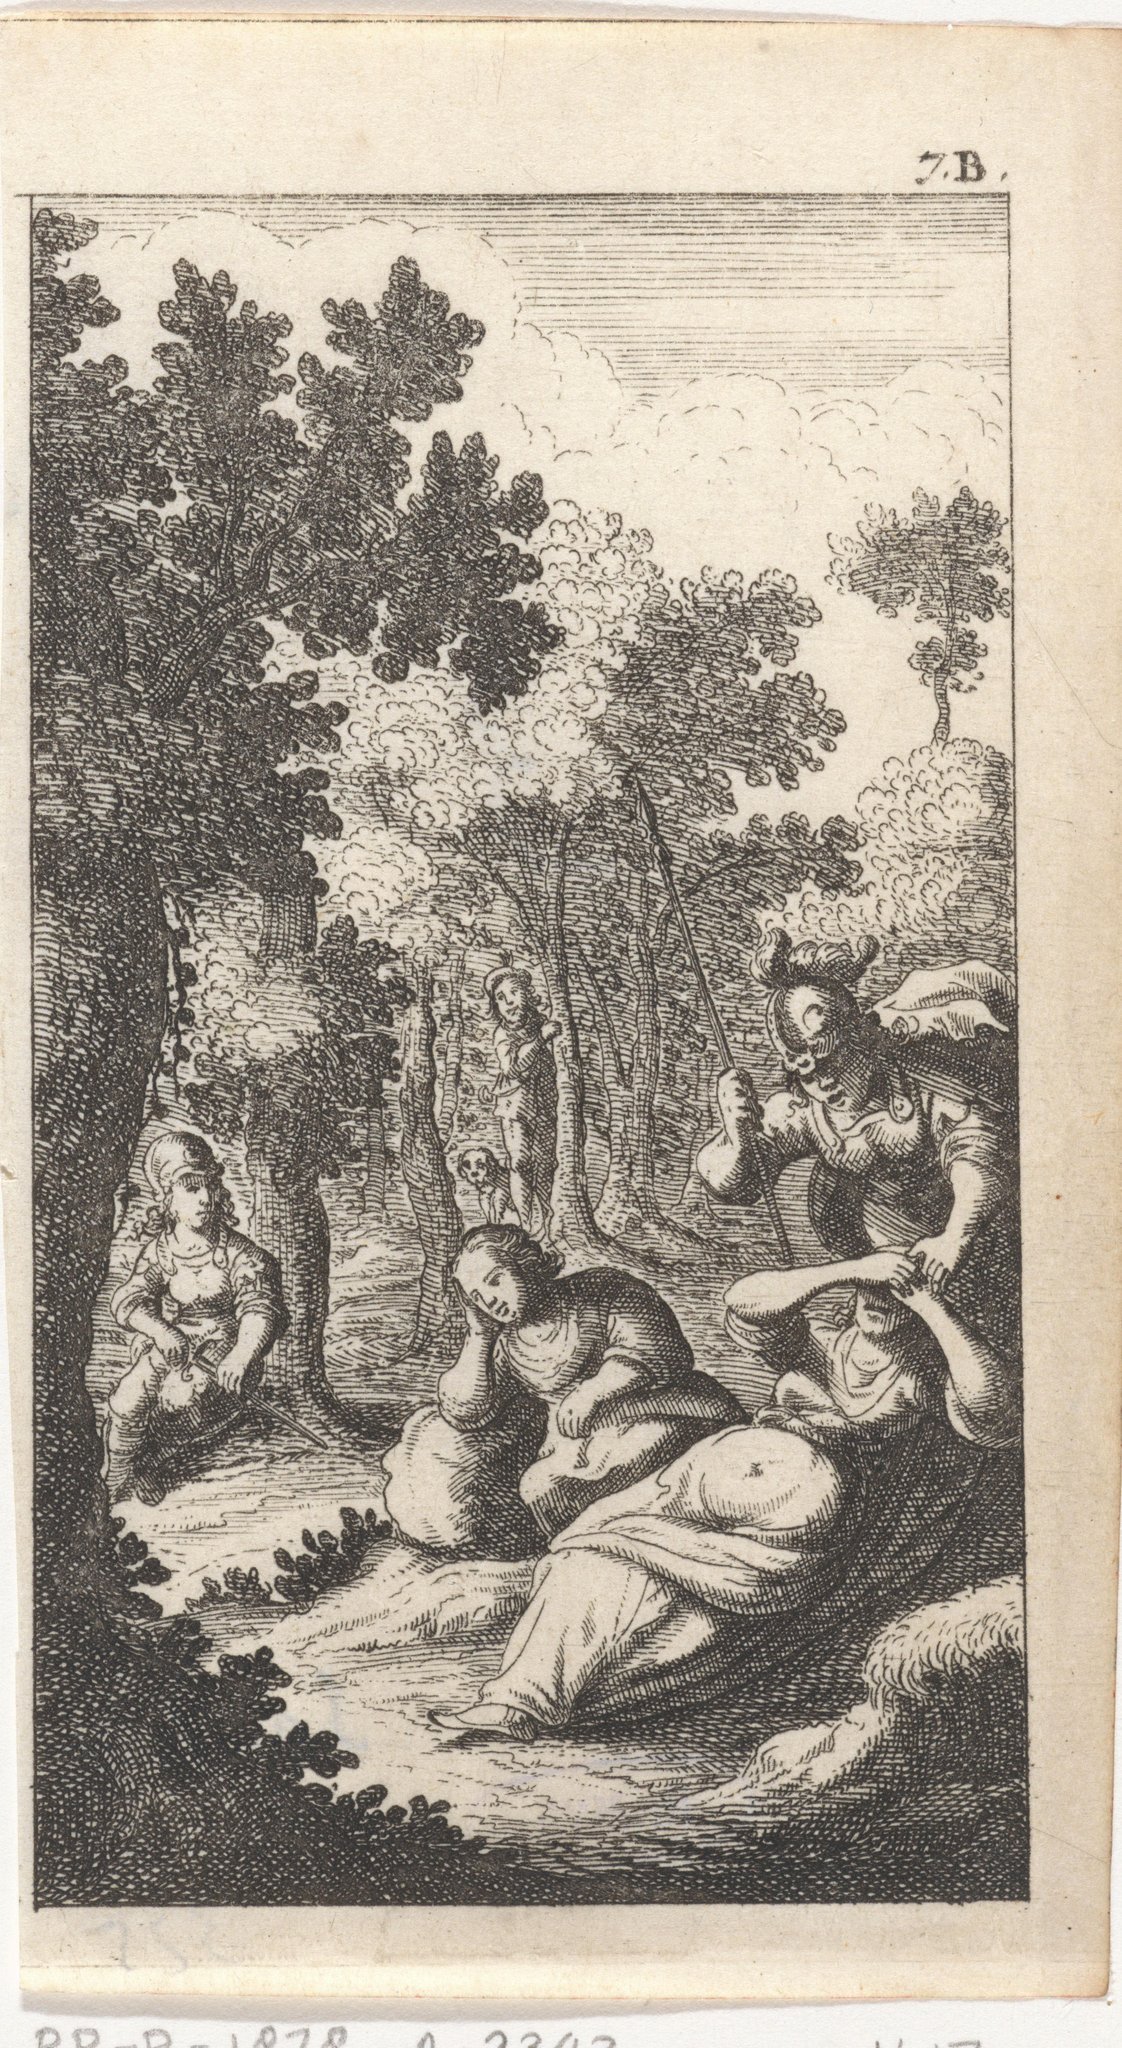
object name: book illustration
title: Soldaat valt een vrouw aan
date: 1667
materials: paper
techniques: etching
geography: netherlands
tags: adult woman, hunter, forest, wood, (military) attack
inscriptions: collector's mark: Lugt 2228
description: In een bos zitten twee vrouwen. De rechter vrouw bedekt haar ogen met haar handen. Een soldaat valt haar van achteren met een speer aan. Links zit een tweede soldaat tegen een boom. Een jager met een hond slaat het tafereel op afstand gade. Rechtsboven: 7. B.